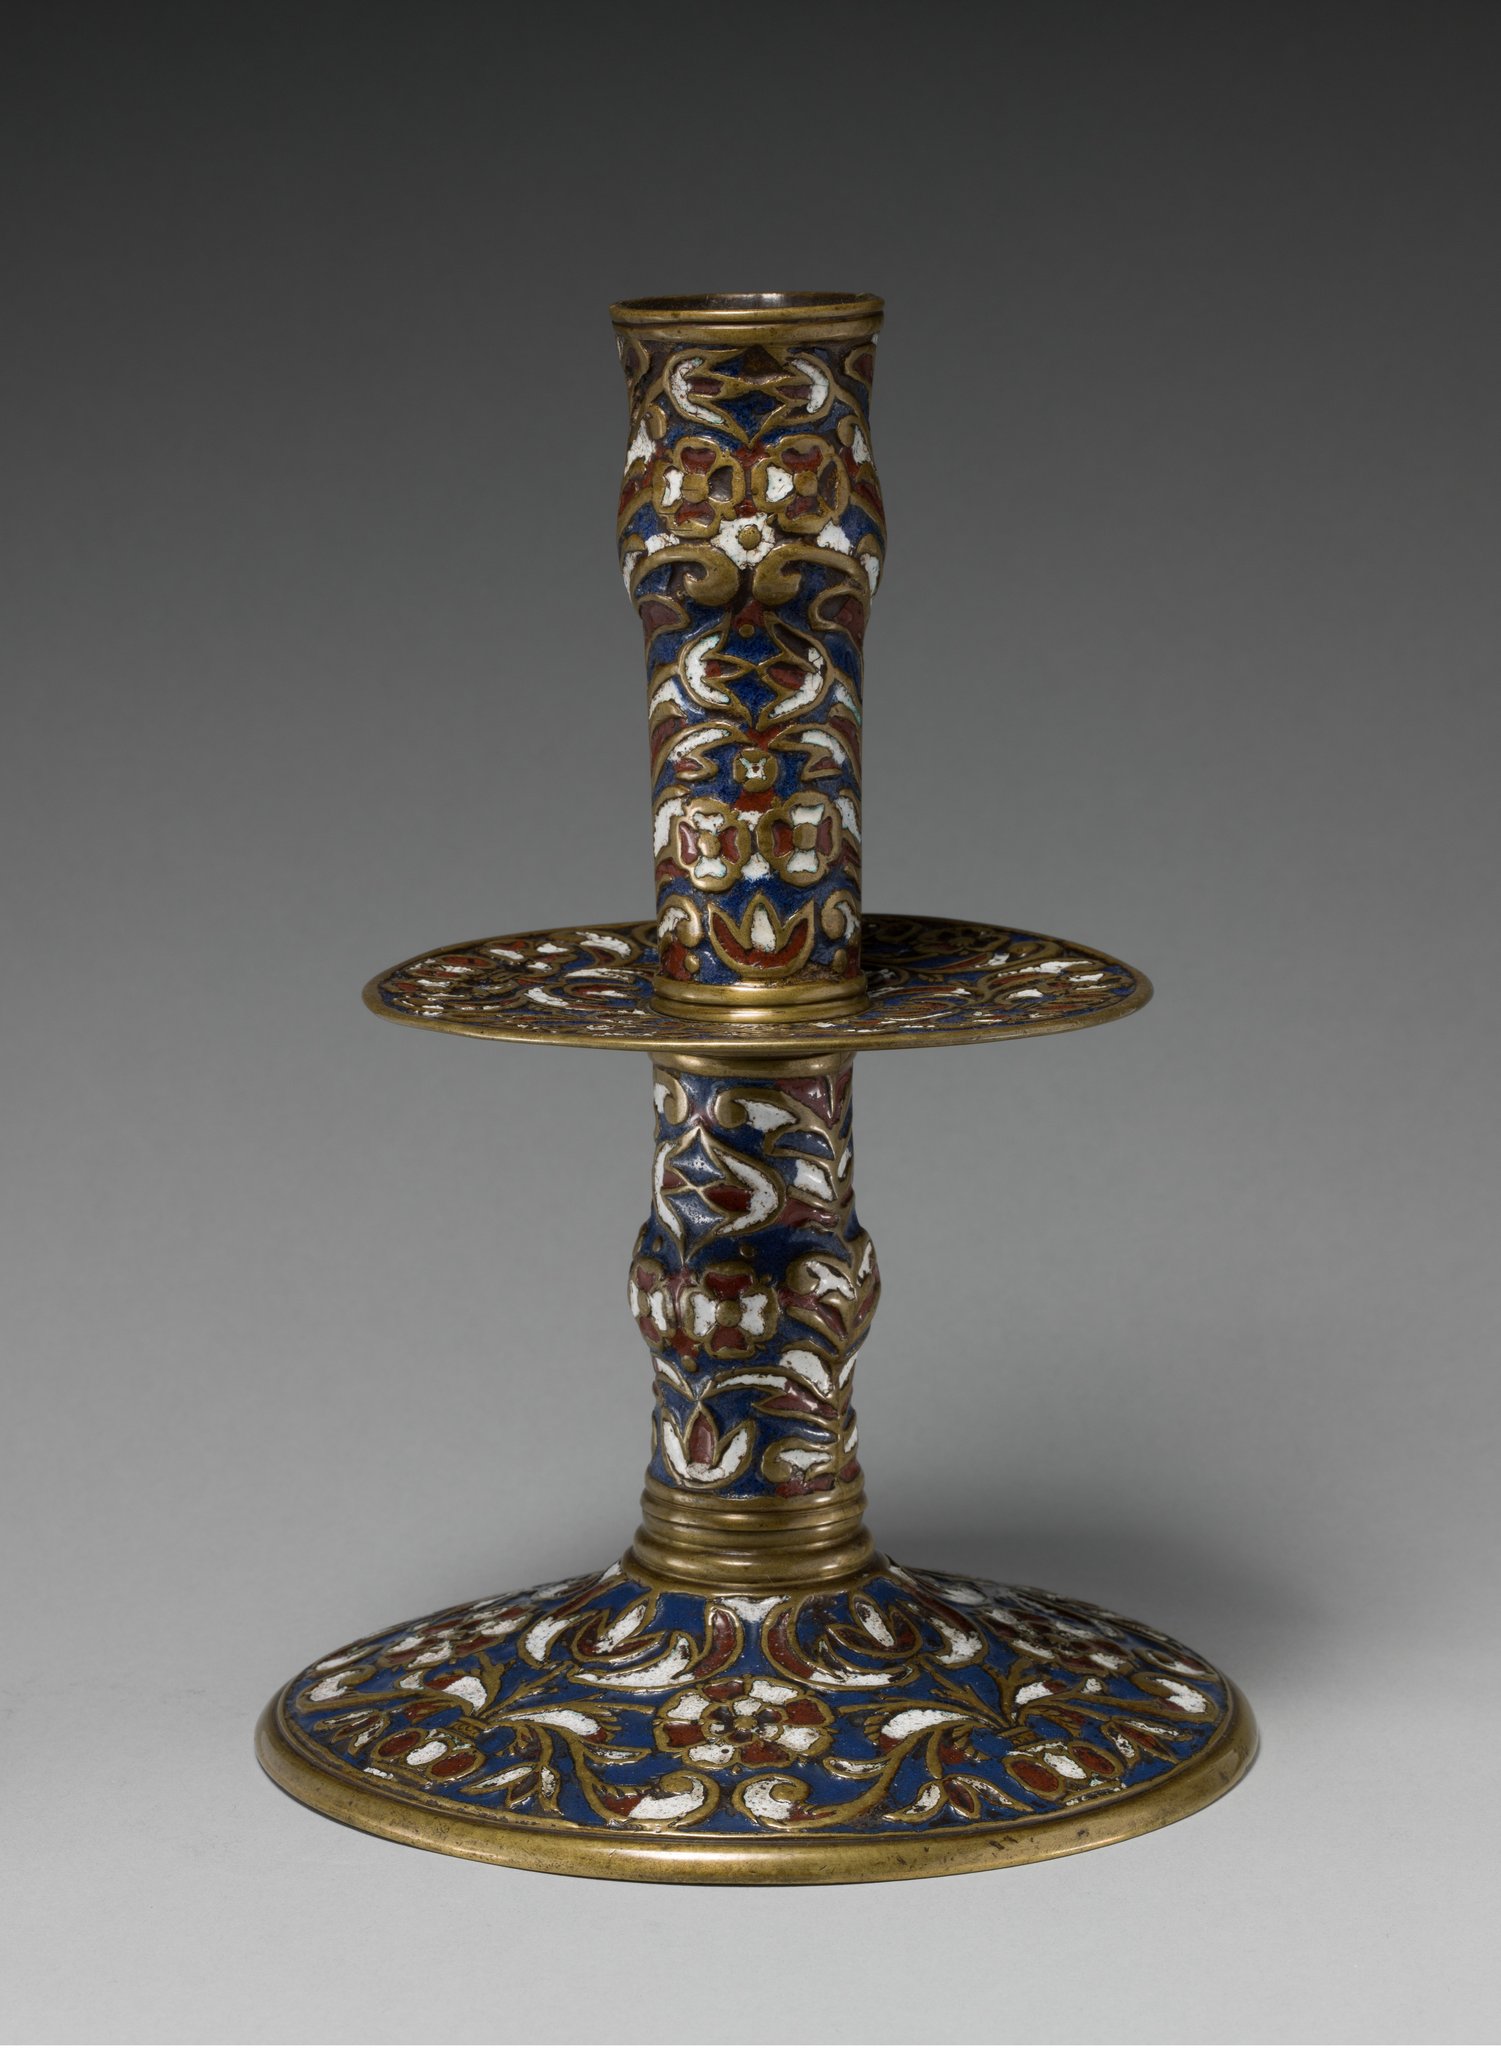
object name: candlestick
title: Pair of candlesticks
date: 1666-1699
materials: brass, enamel